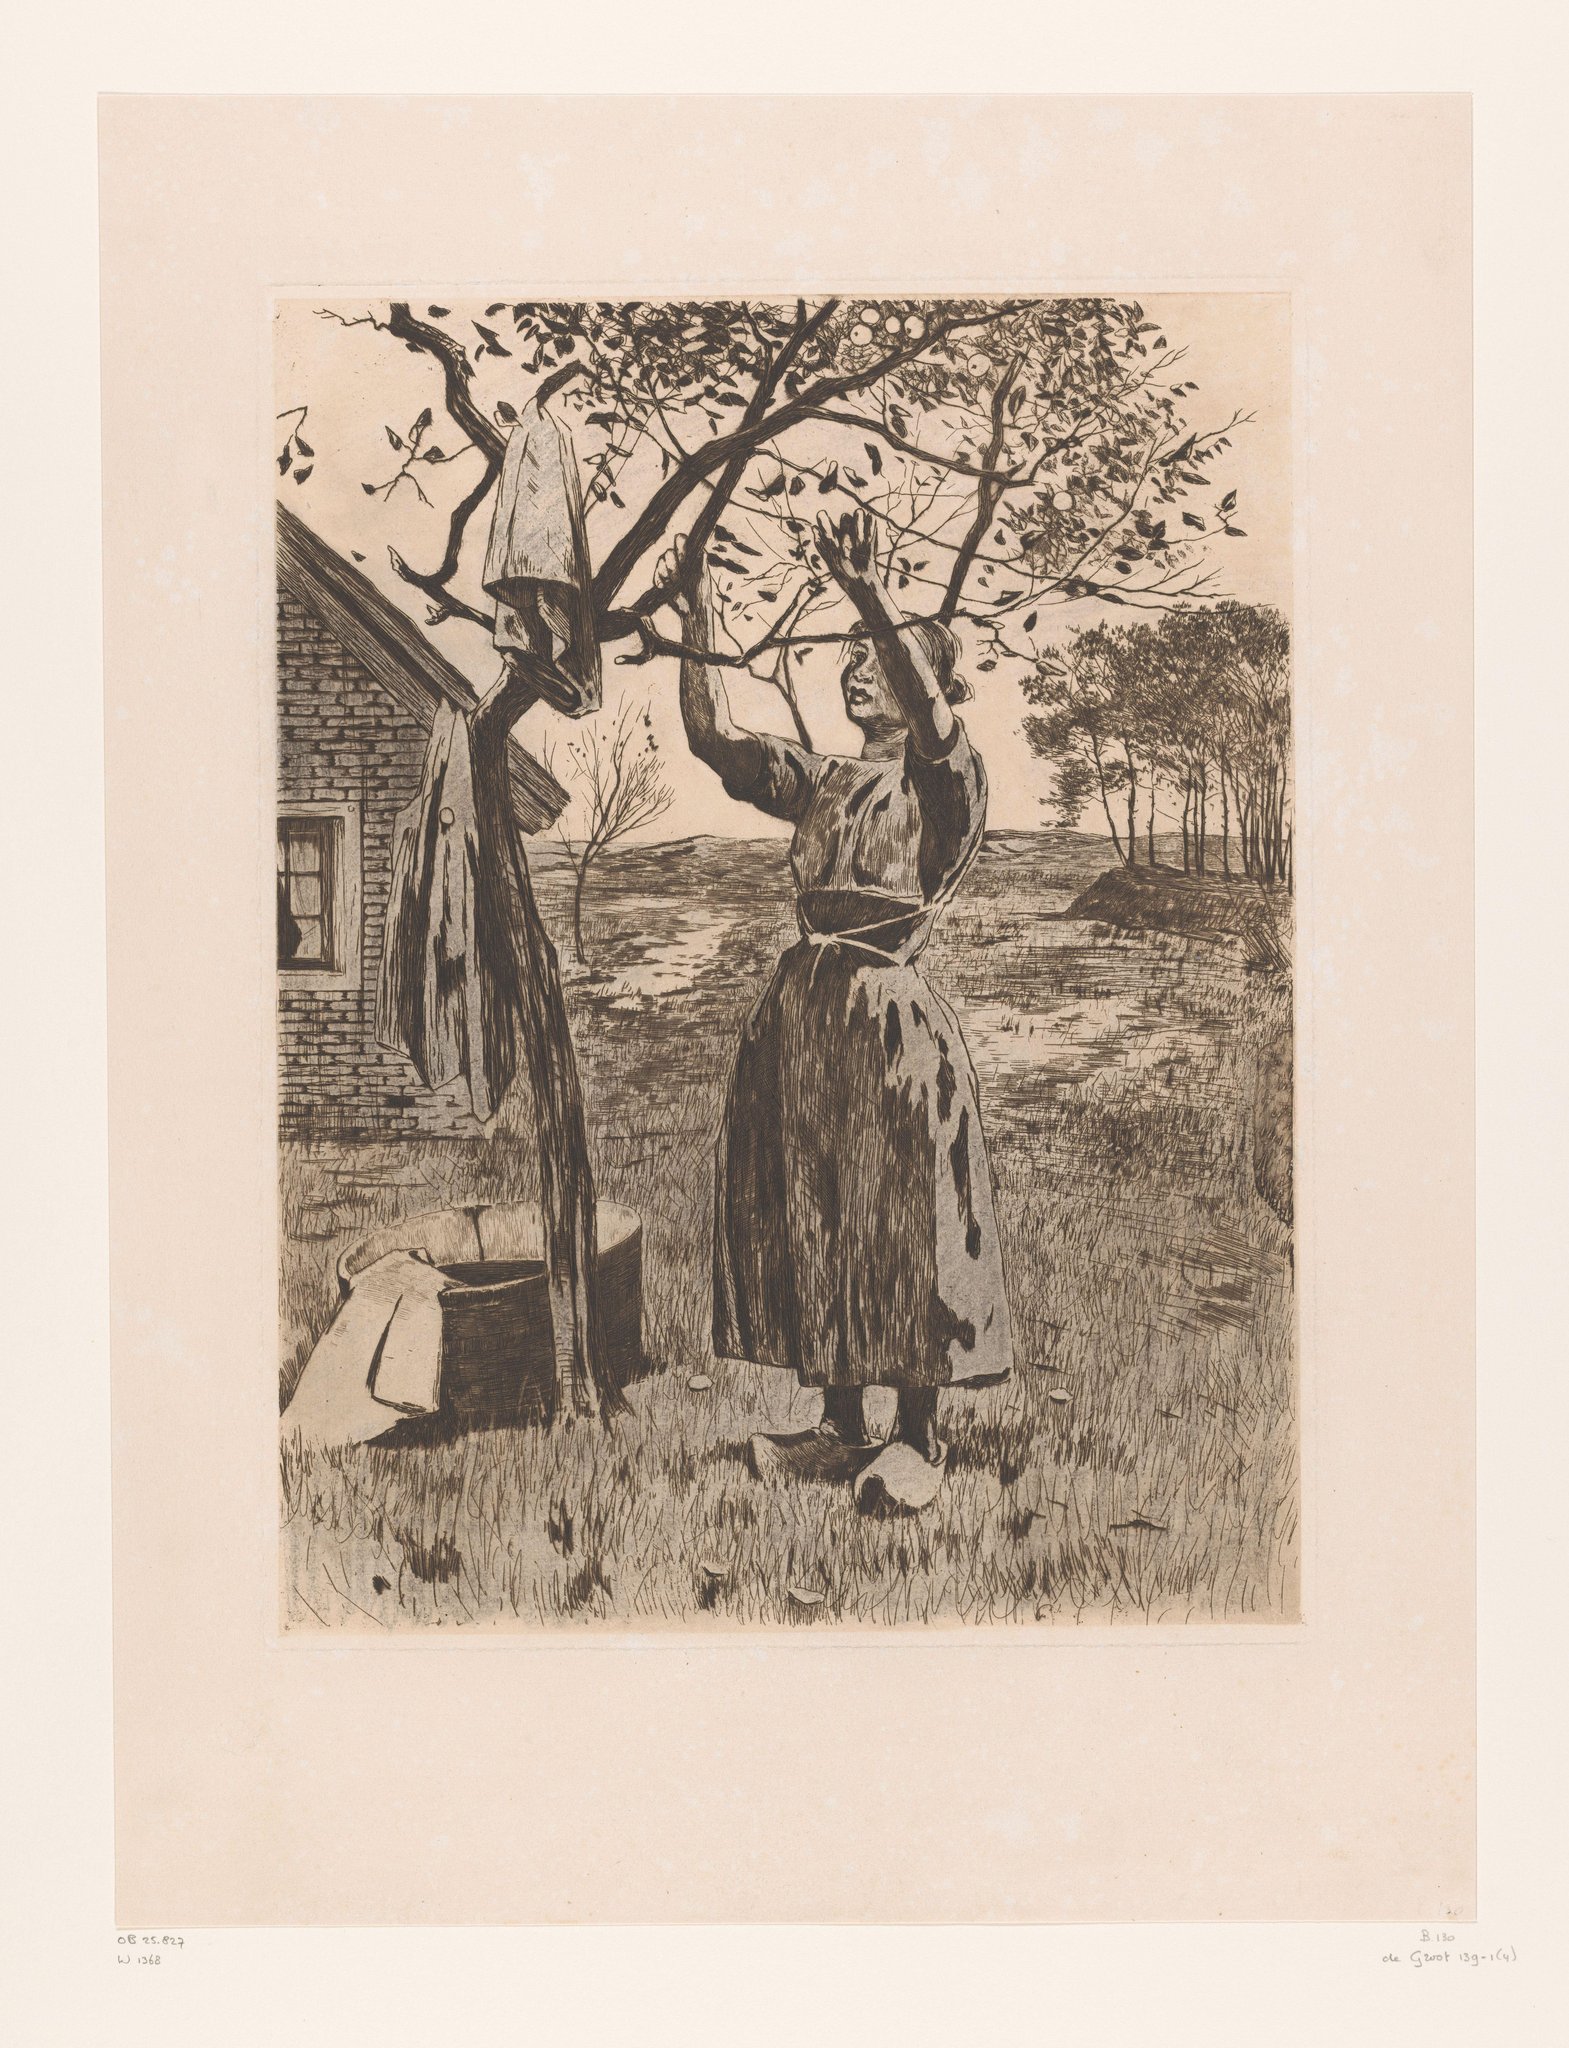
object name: print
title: Vrouw reikt omhoog naar de takken van een appelboom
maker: willem witsen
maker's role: draughtsman, painter, print maker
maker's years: 1860-1923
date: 1908-1909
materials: chalk, paper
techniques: etching, intaglio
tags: farmers - aa - female farmer, farmer's wife, farm or solitary house in landscape, hanging the wash to dry